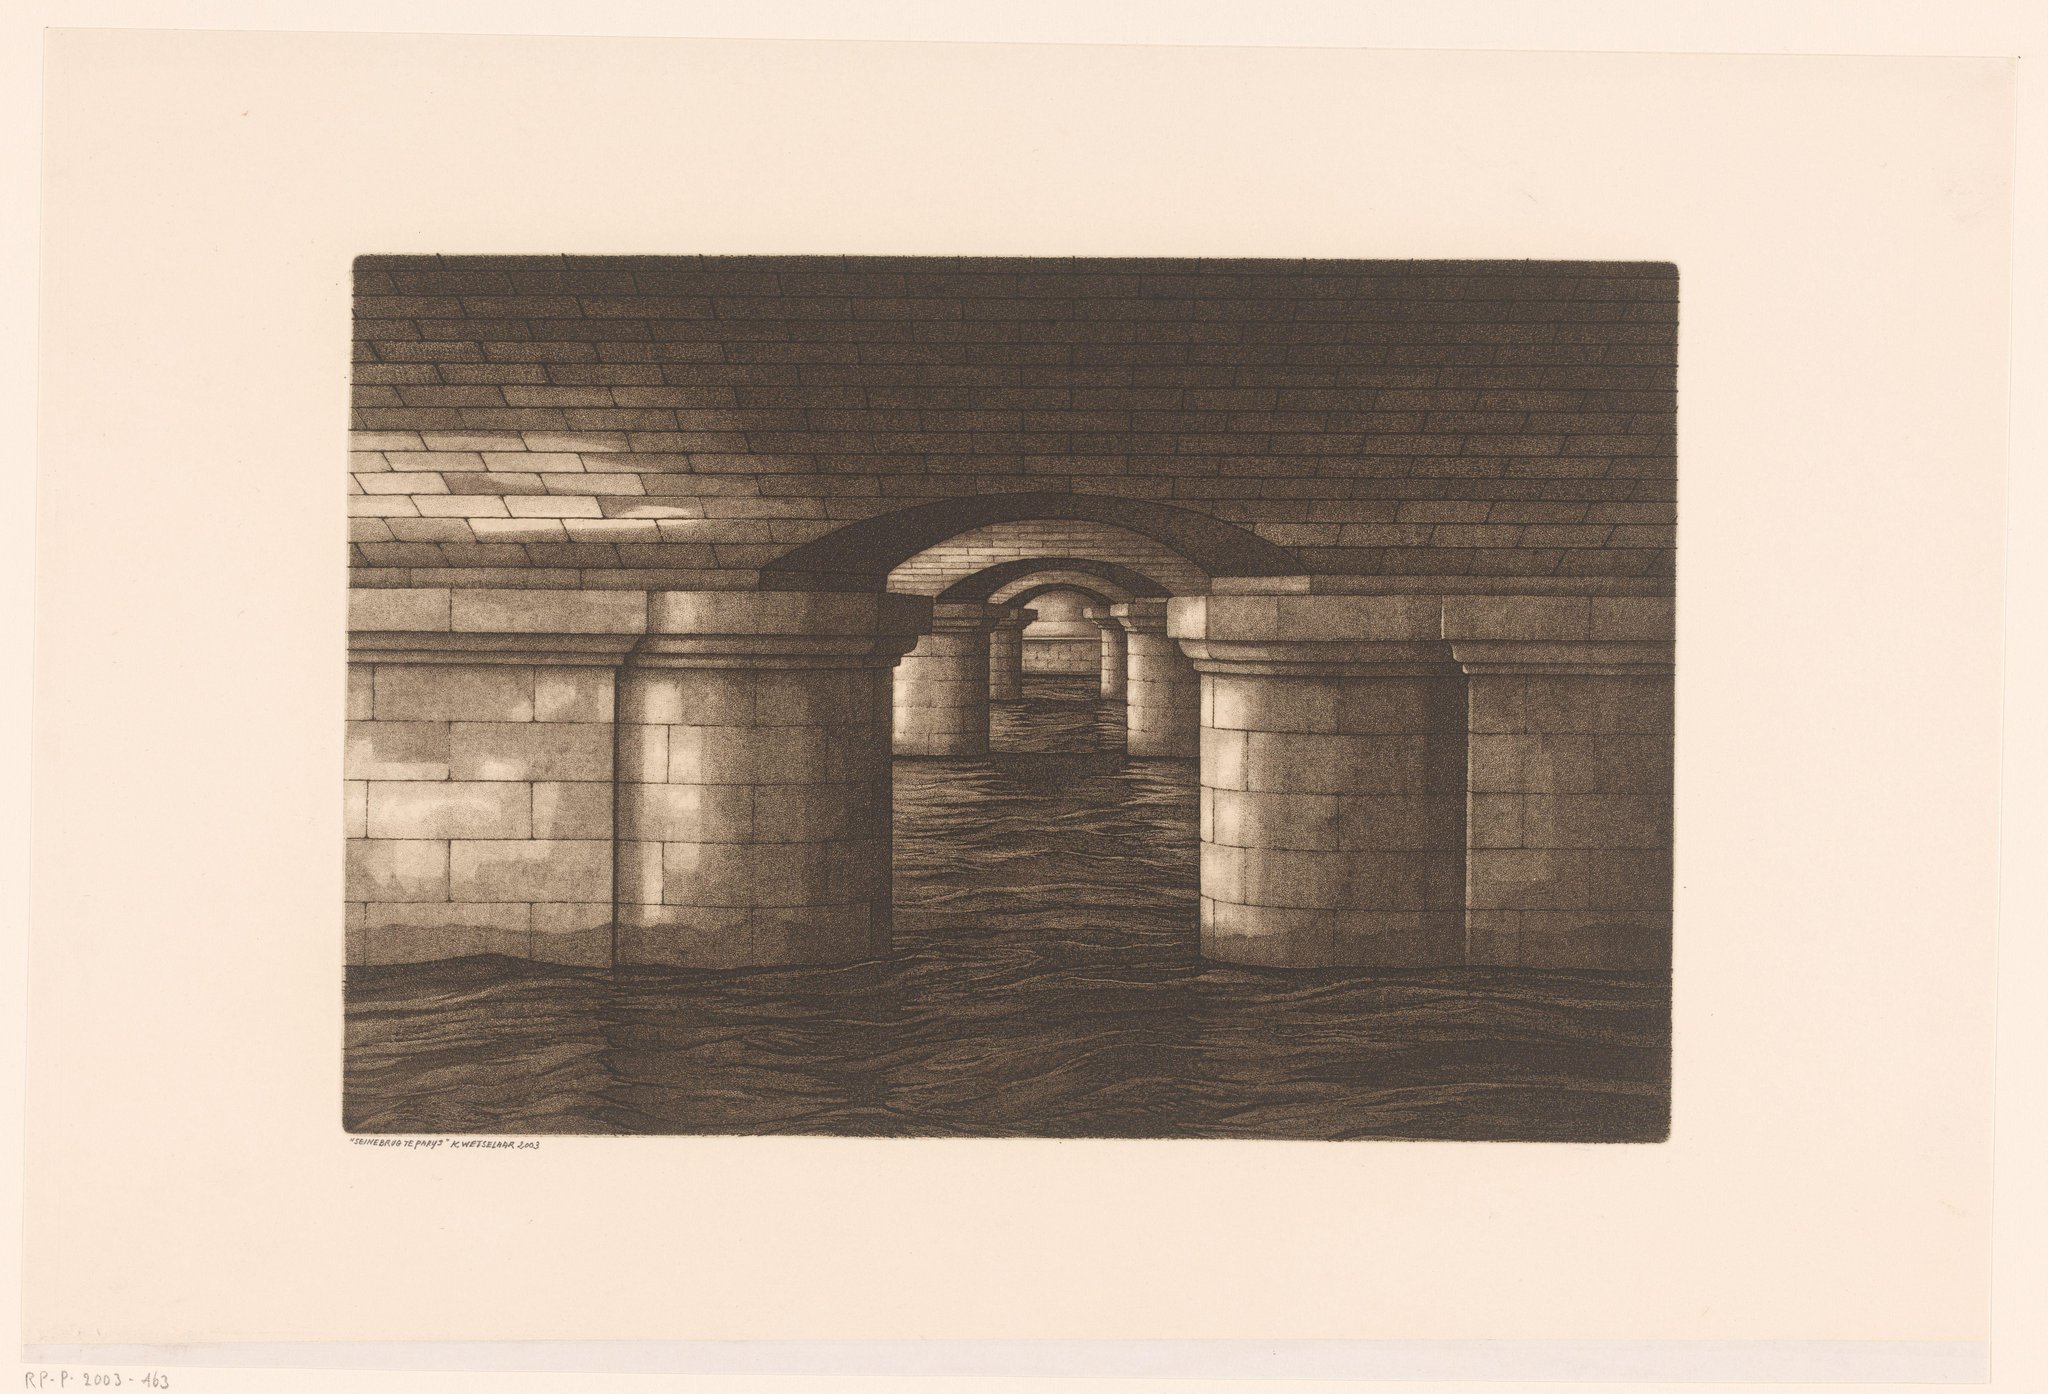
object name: print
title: Scène uit La Gerusalemme Liberata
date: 1745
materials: paper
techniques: etching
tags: fruits and vegetables ~ ornament, (scenes from) specific works of literature: tasso, gerusalemme liberata, armorial bearing, heraldry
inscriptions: collector's mark: Lugt 2228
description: Ornamentrand met bloemen, planten, cupido's en een fontein.